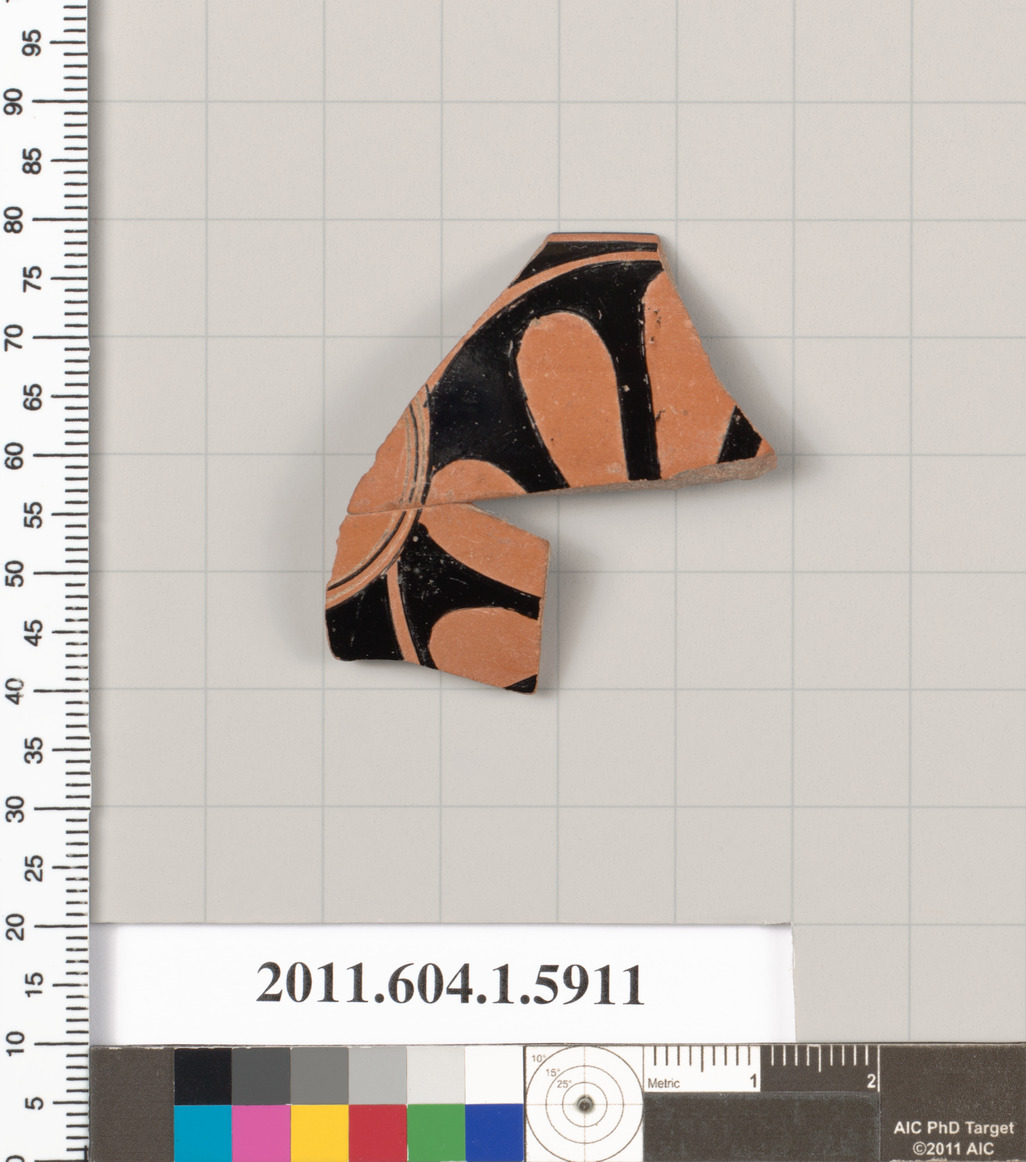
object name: kylix fragment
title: Terracotta rim fragment of a kylix (drinking cup)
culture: greek, attic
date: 520-510 BCE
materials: terracotta